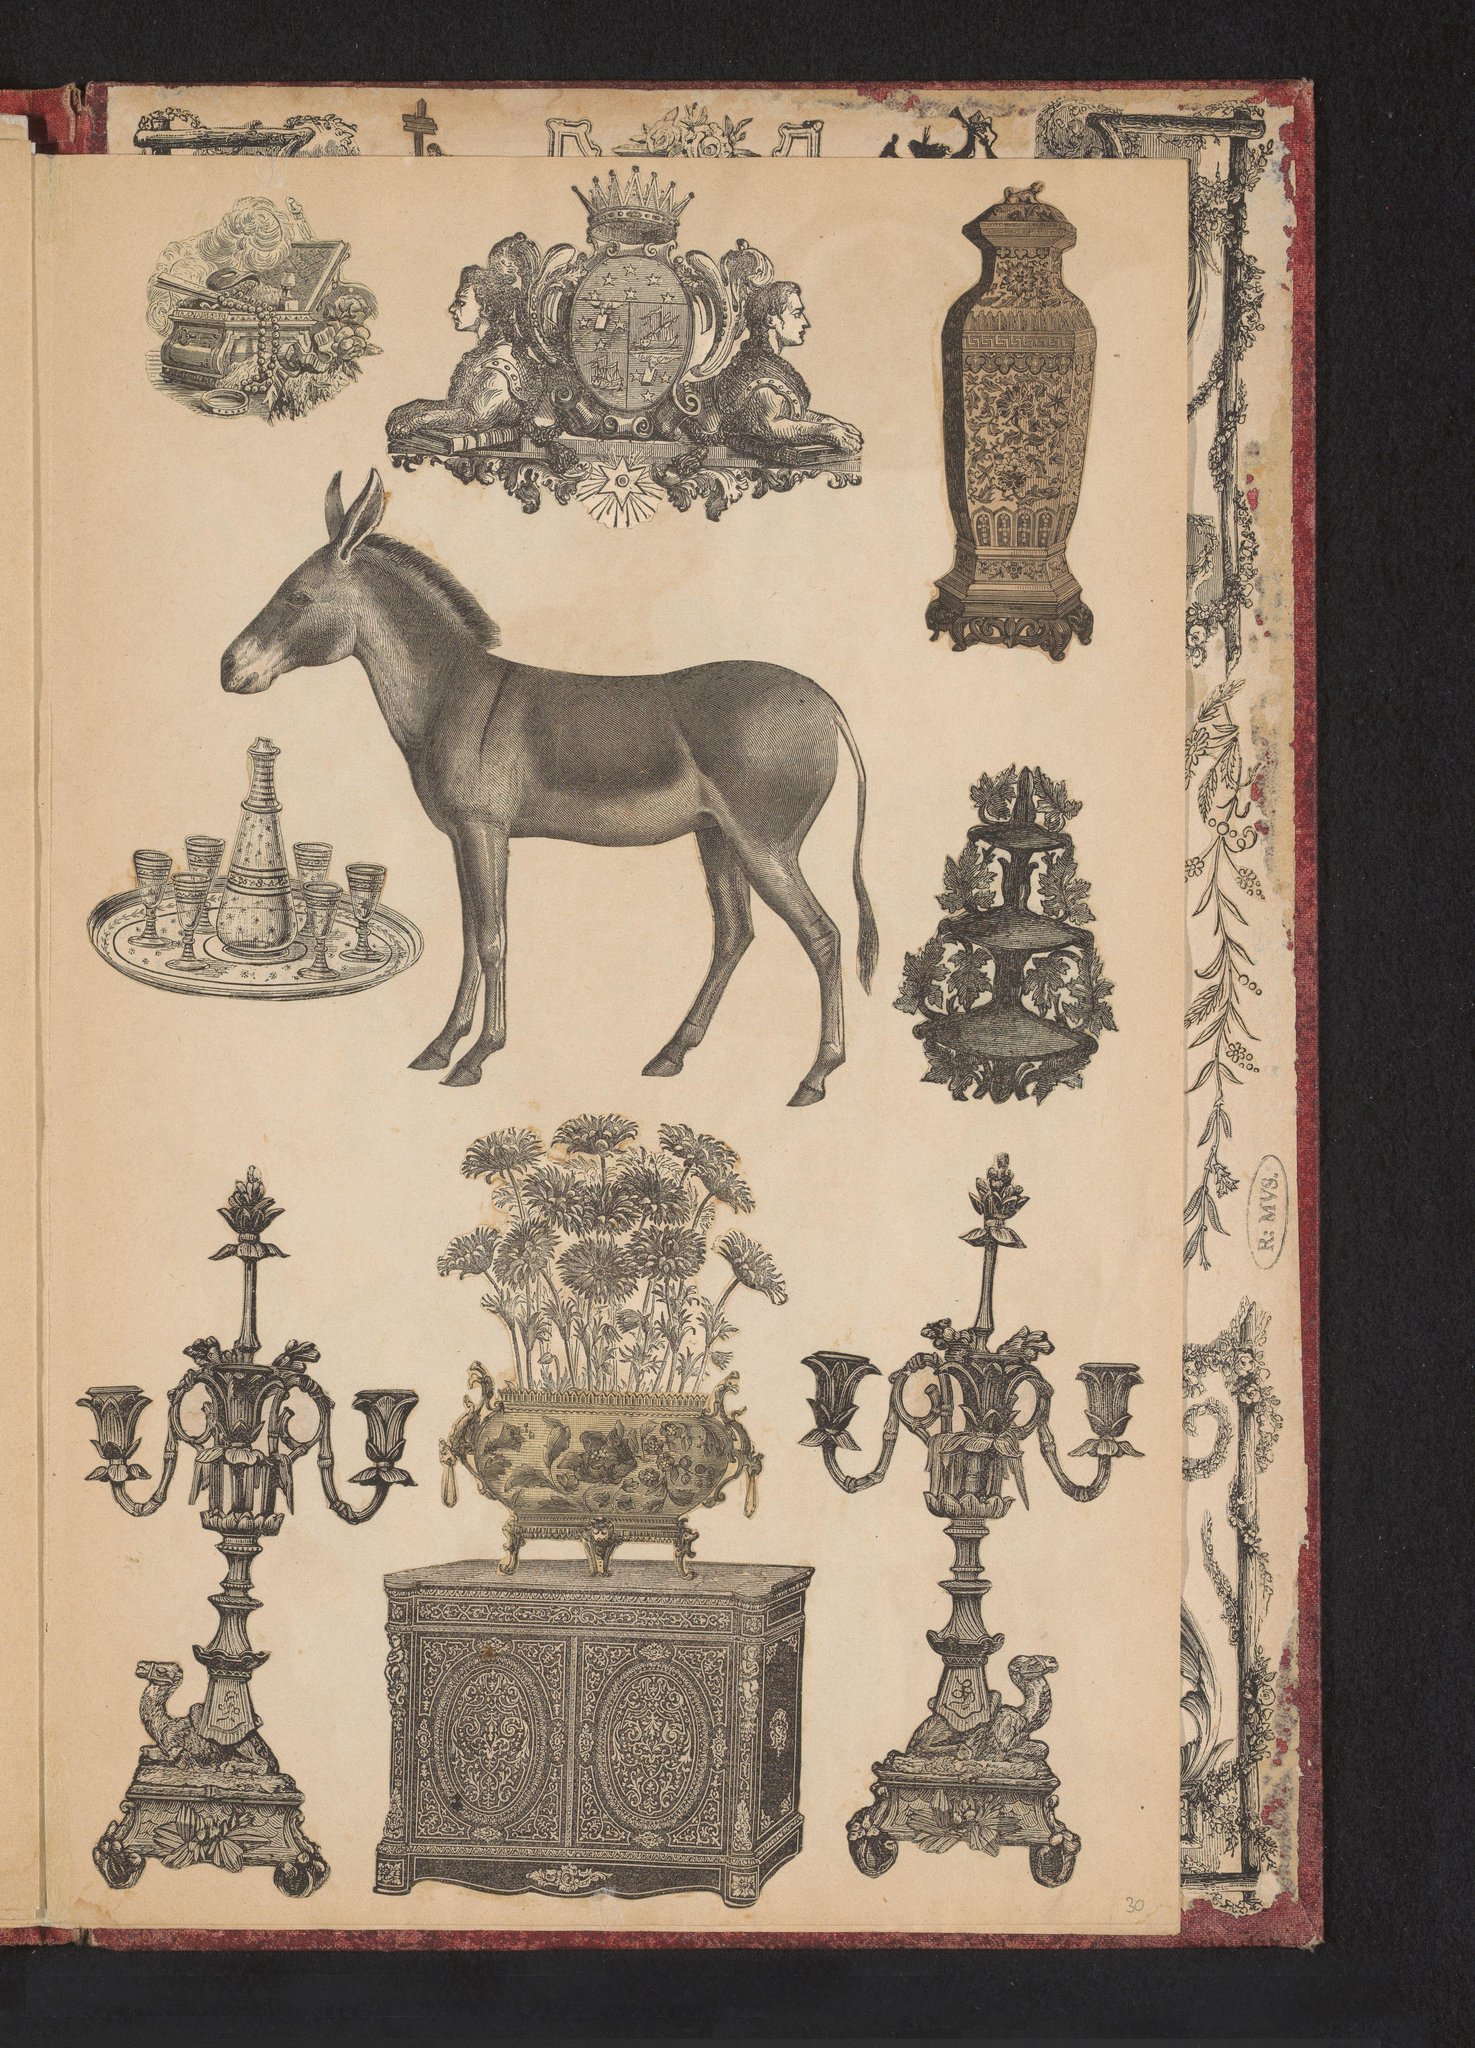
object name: collage visual work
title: Collage van uitgeknipte prenten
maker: Anonymous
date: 1870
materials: paper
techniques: engraving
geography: paris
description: Collage van uitgeknipte prenten. Onderdeel van een album met 32 bladen, aan beide zijden beplakt met uitgeknipte prenten, vermoedelijk afkomstig uit 19e-eeuwse tijdschiften.